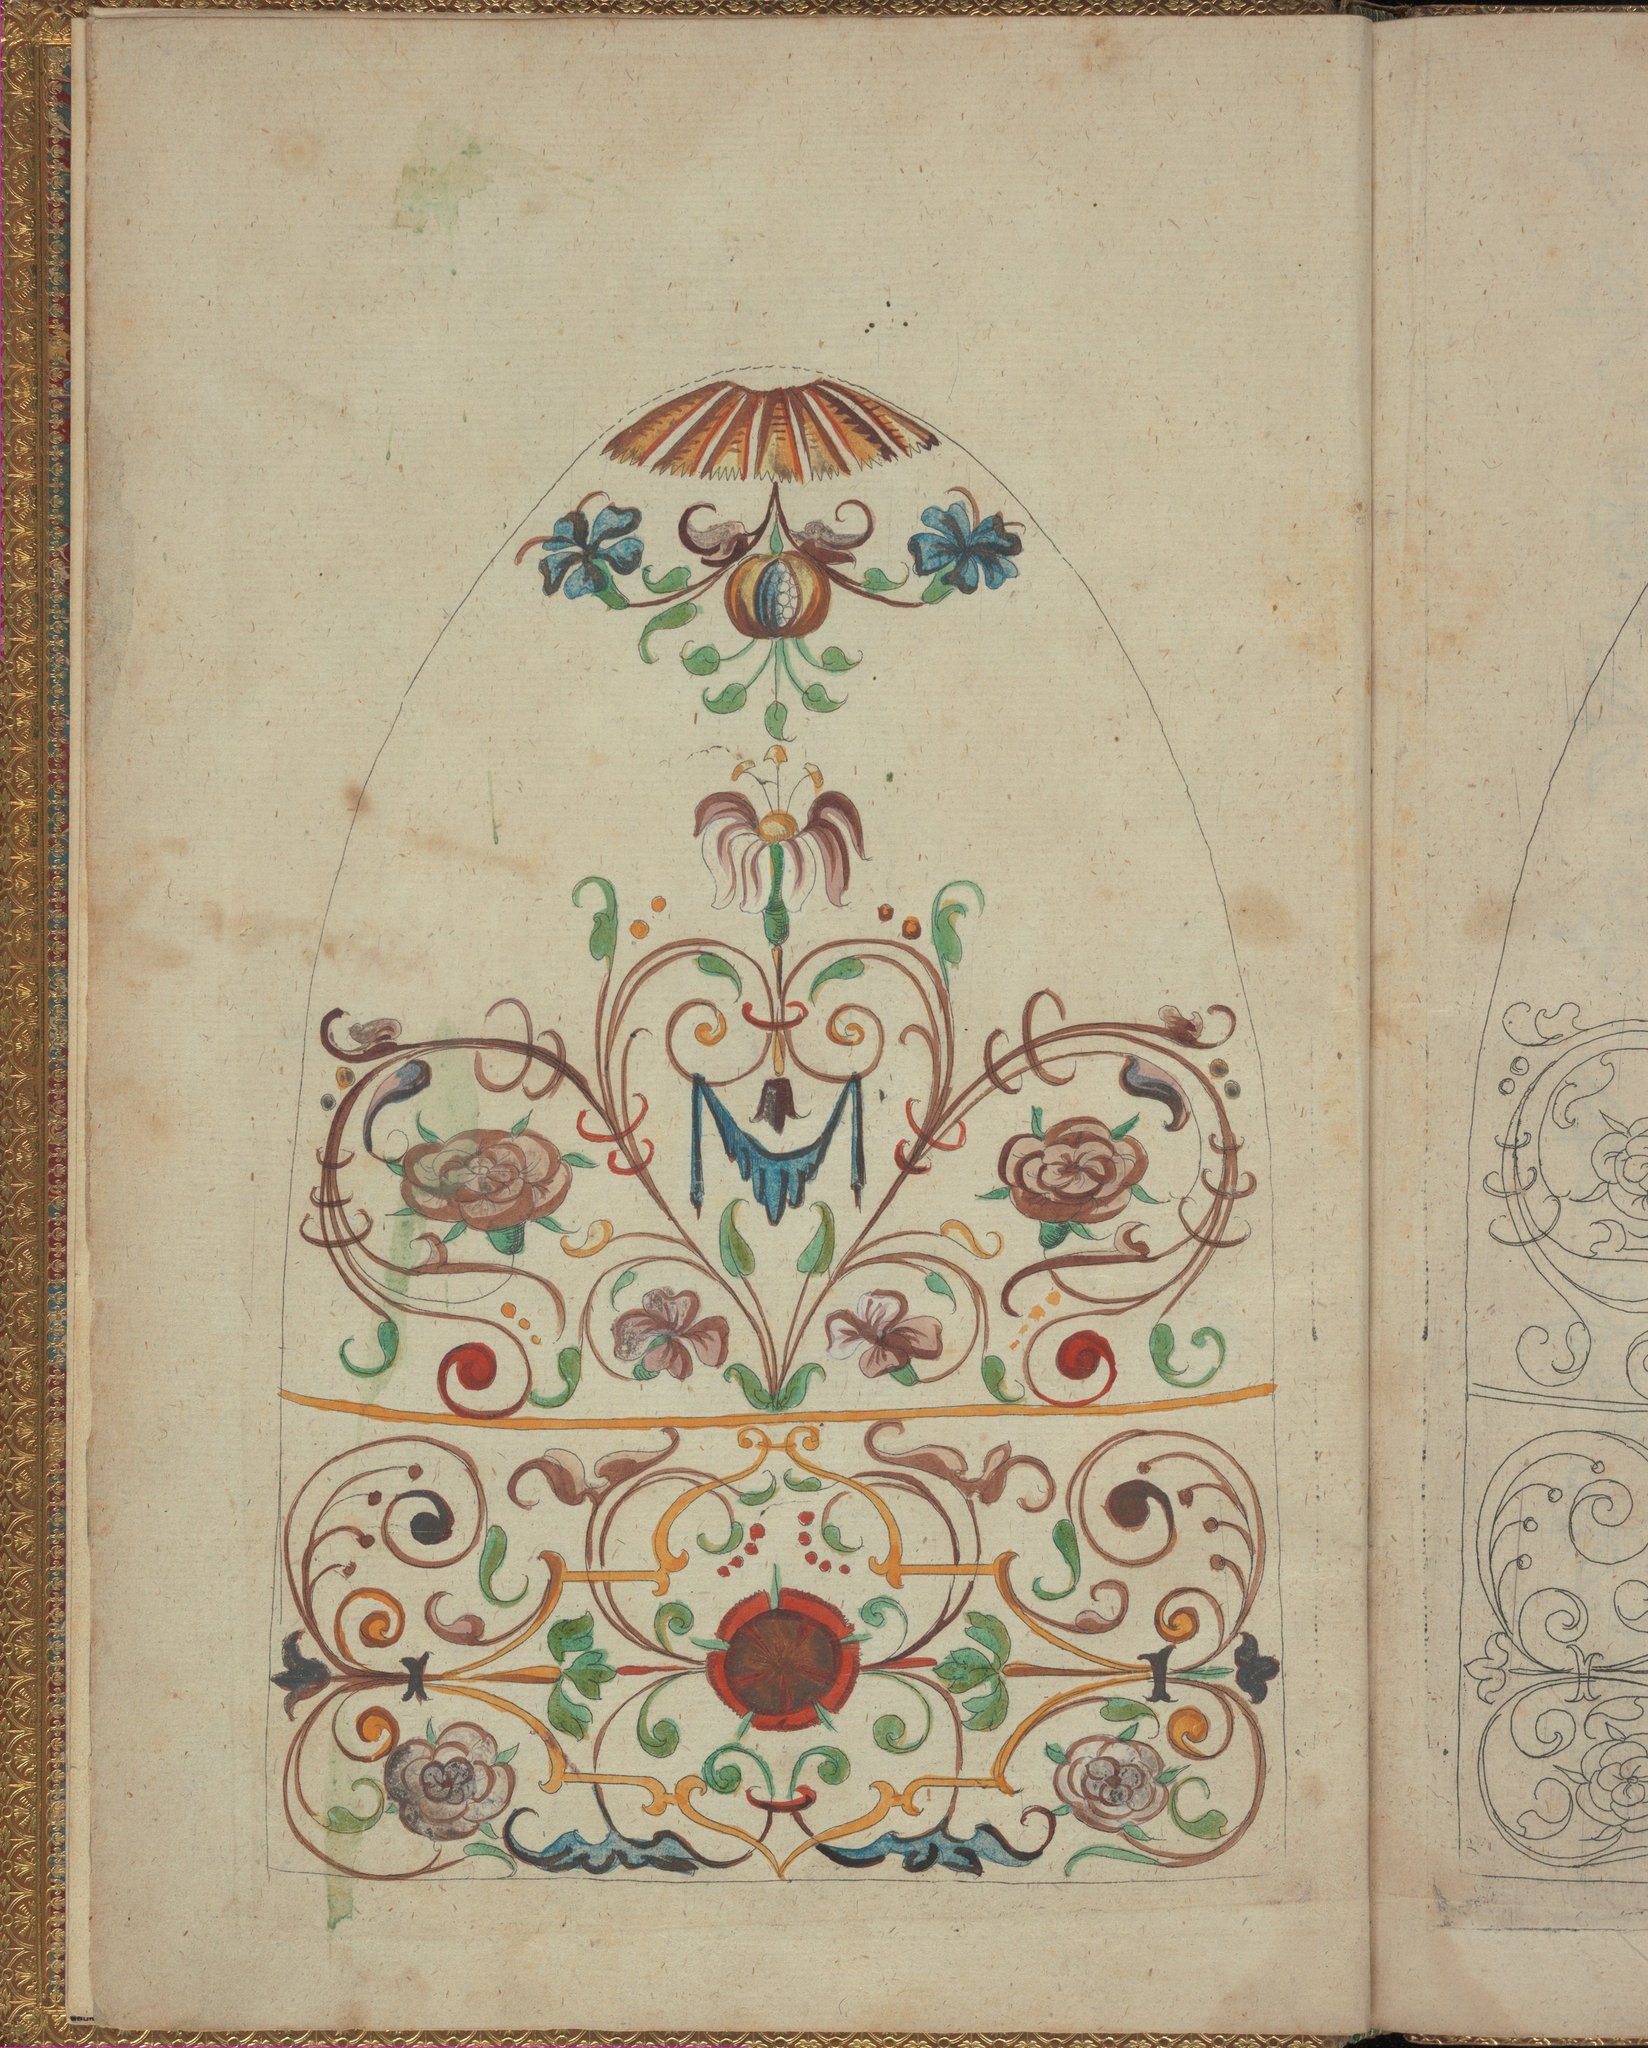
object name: book print ornament architecture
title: New Modelbüch (Page 2v)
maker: andreas bretschneider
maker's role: designer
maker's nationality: german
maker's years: 1573-1645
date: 1615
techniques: etching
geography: germany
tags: flowers